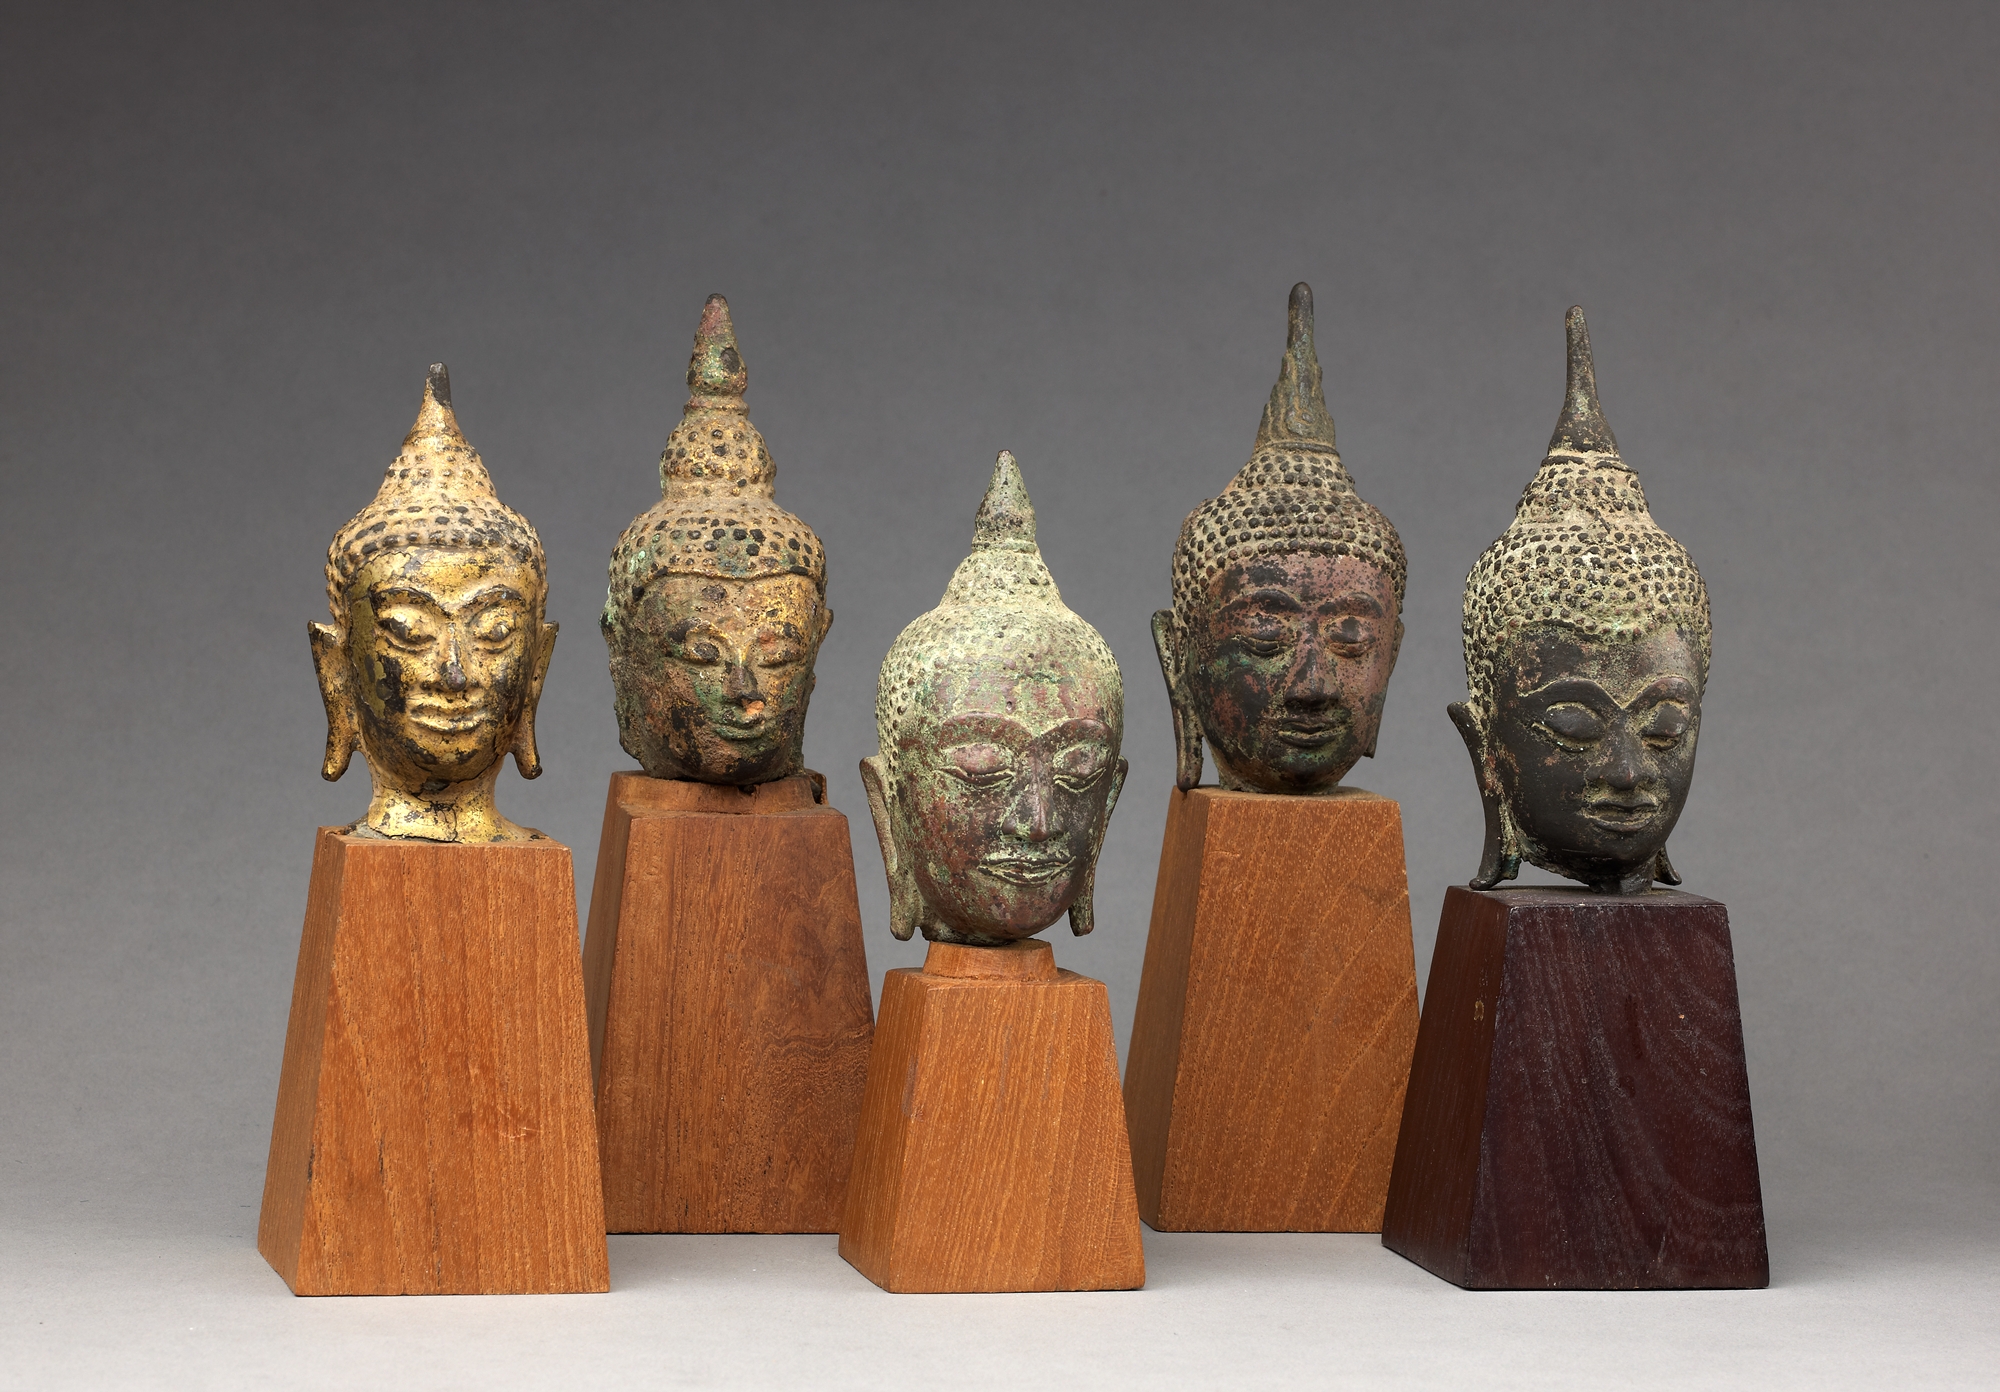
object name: sculpture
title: Head of the Buddha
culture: thai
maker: thai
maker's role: artist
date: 1767-1900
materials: copper alloy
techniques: gilding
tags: heads,buddha